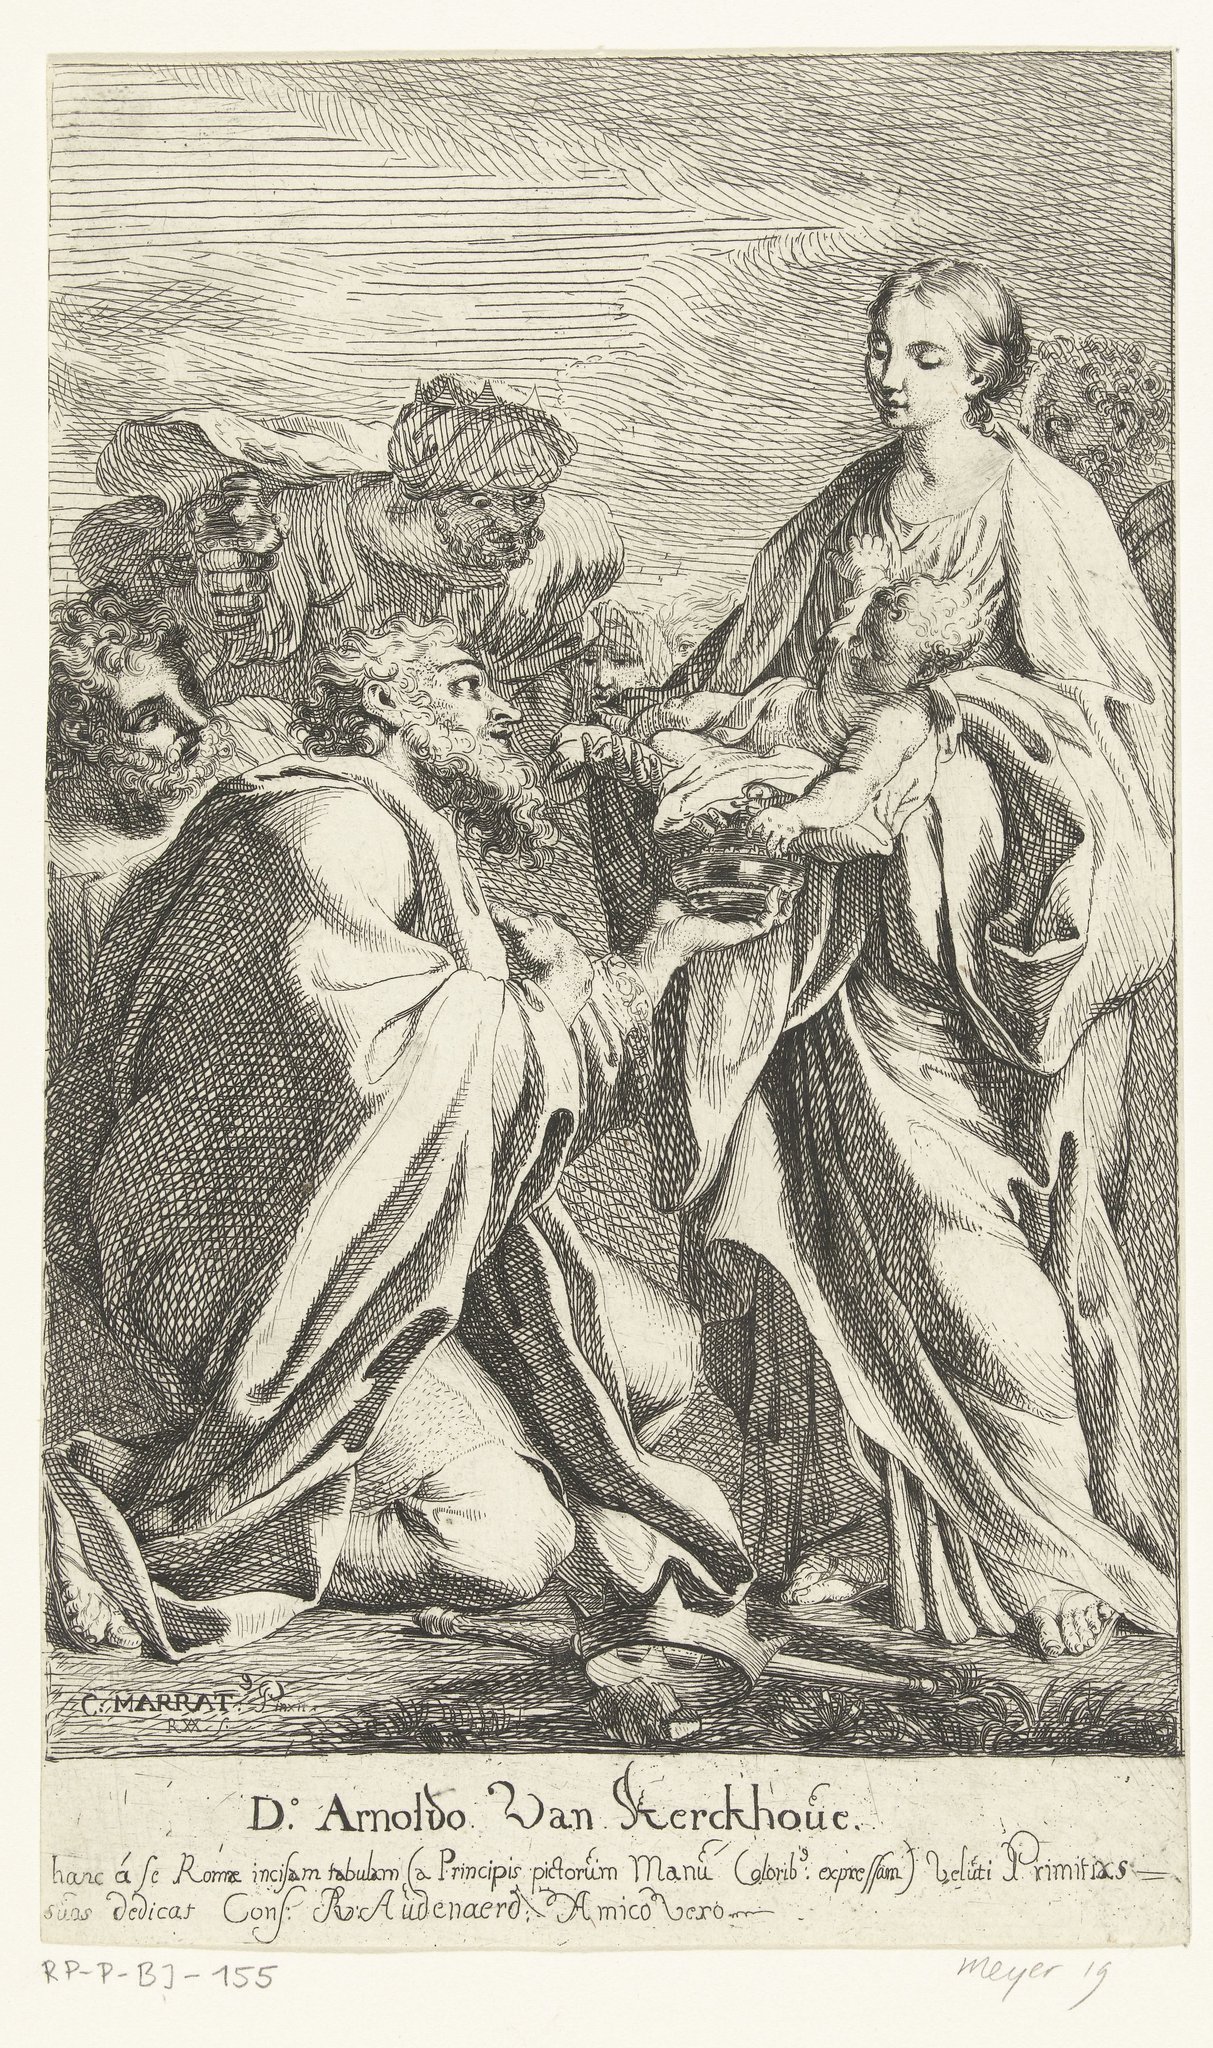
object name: print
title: De aanbidding der koningen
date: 1685-1700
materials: paper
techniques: engraving, etching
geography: rome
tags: adoration of the kings: the wise men present their gifts to the christ-child (gold, frankincense and myrrh)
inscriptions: collector's mark: Lugt 2228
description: Maria met het Christuskind in haar armen ontvangt de geschenken van de drie koningen.